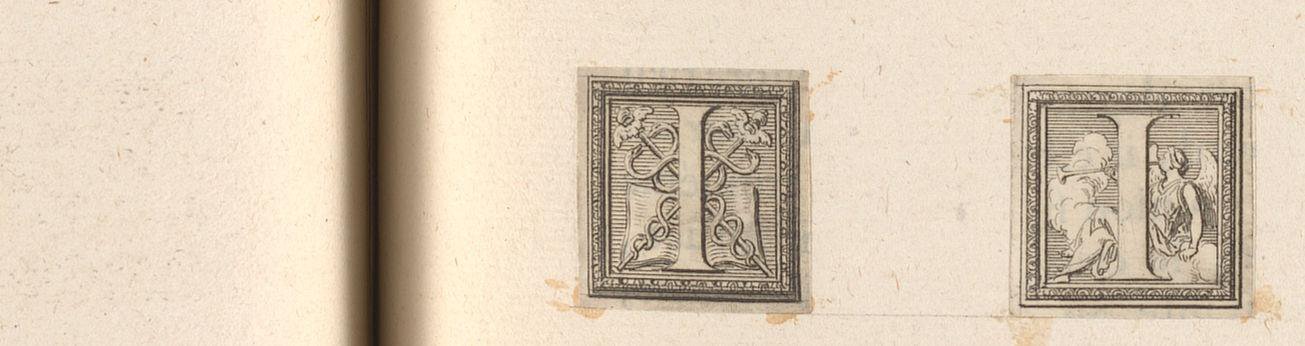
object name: album leaf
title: Initiaal 'I' met twee caducei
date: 1680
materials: paper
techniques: etching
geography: paris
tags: initial, caduceus (staff with two snakes, attribute of mercury)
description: Prent gebruikt voor: Tallemant, Abbé Paul. Panegyriques et harangues à la louange du Roy (...). Parijs: Pierre Le Petit, 1680.